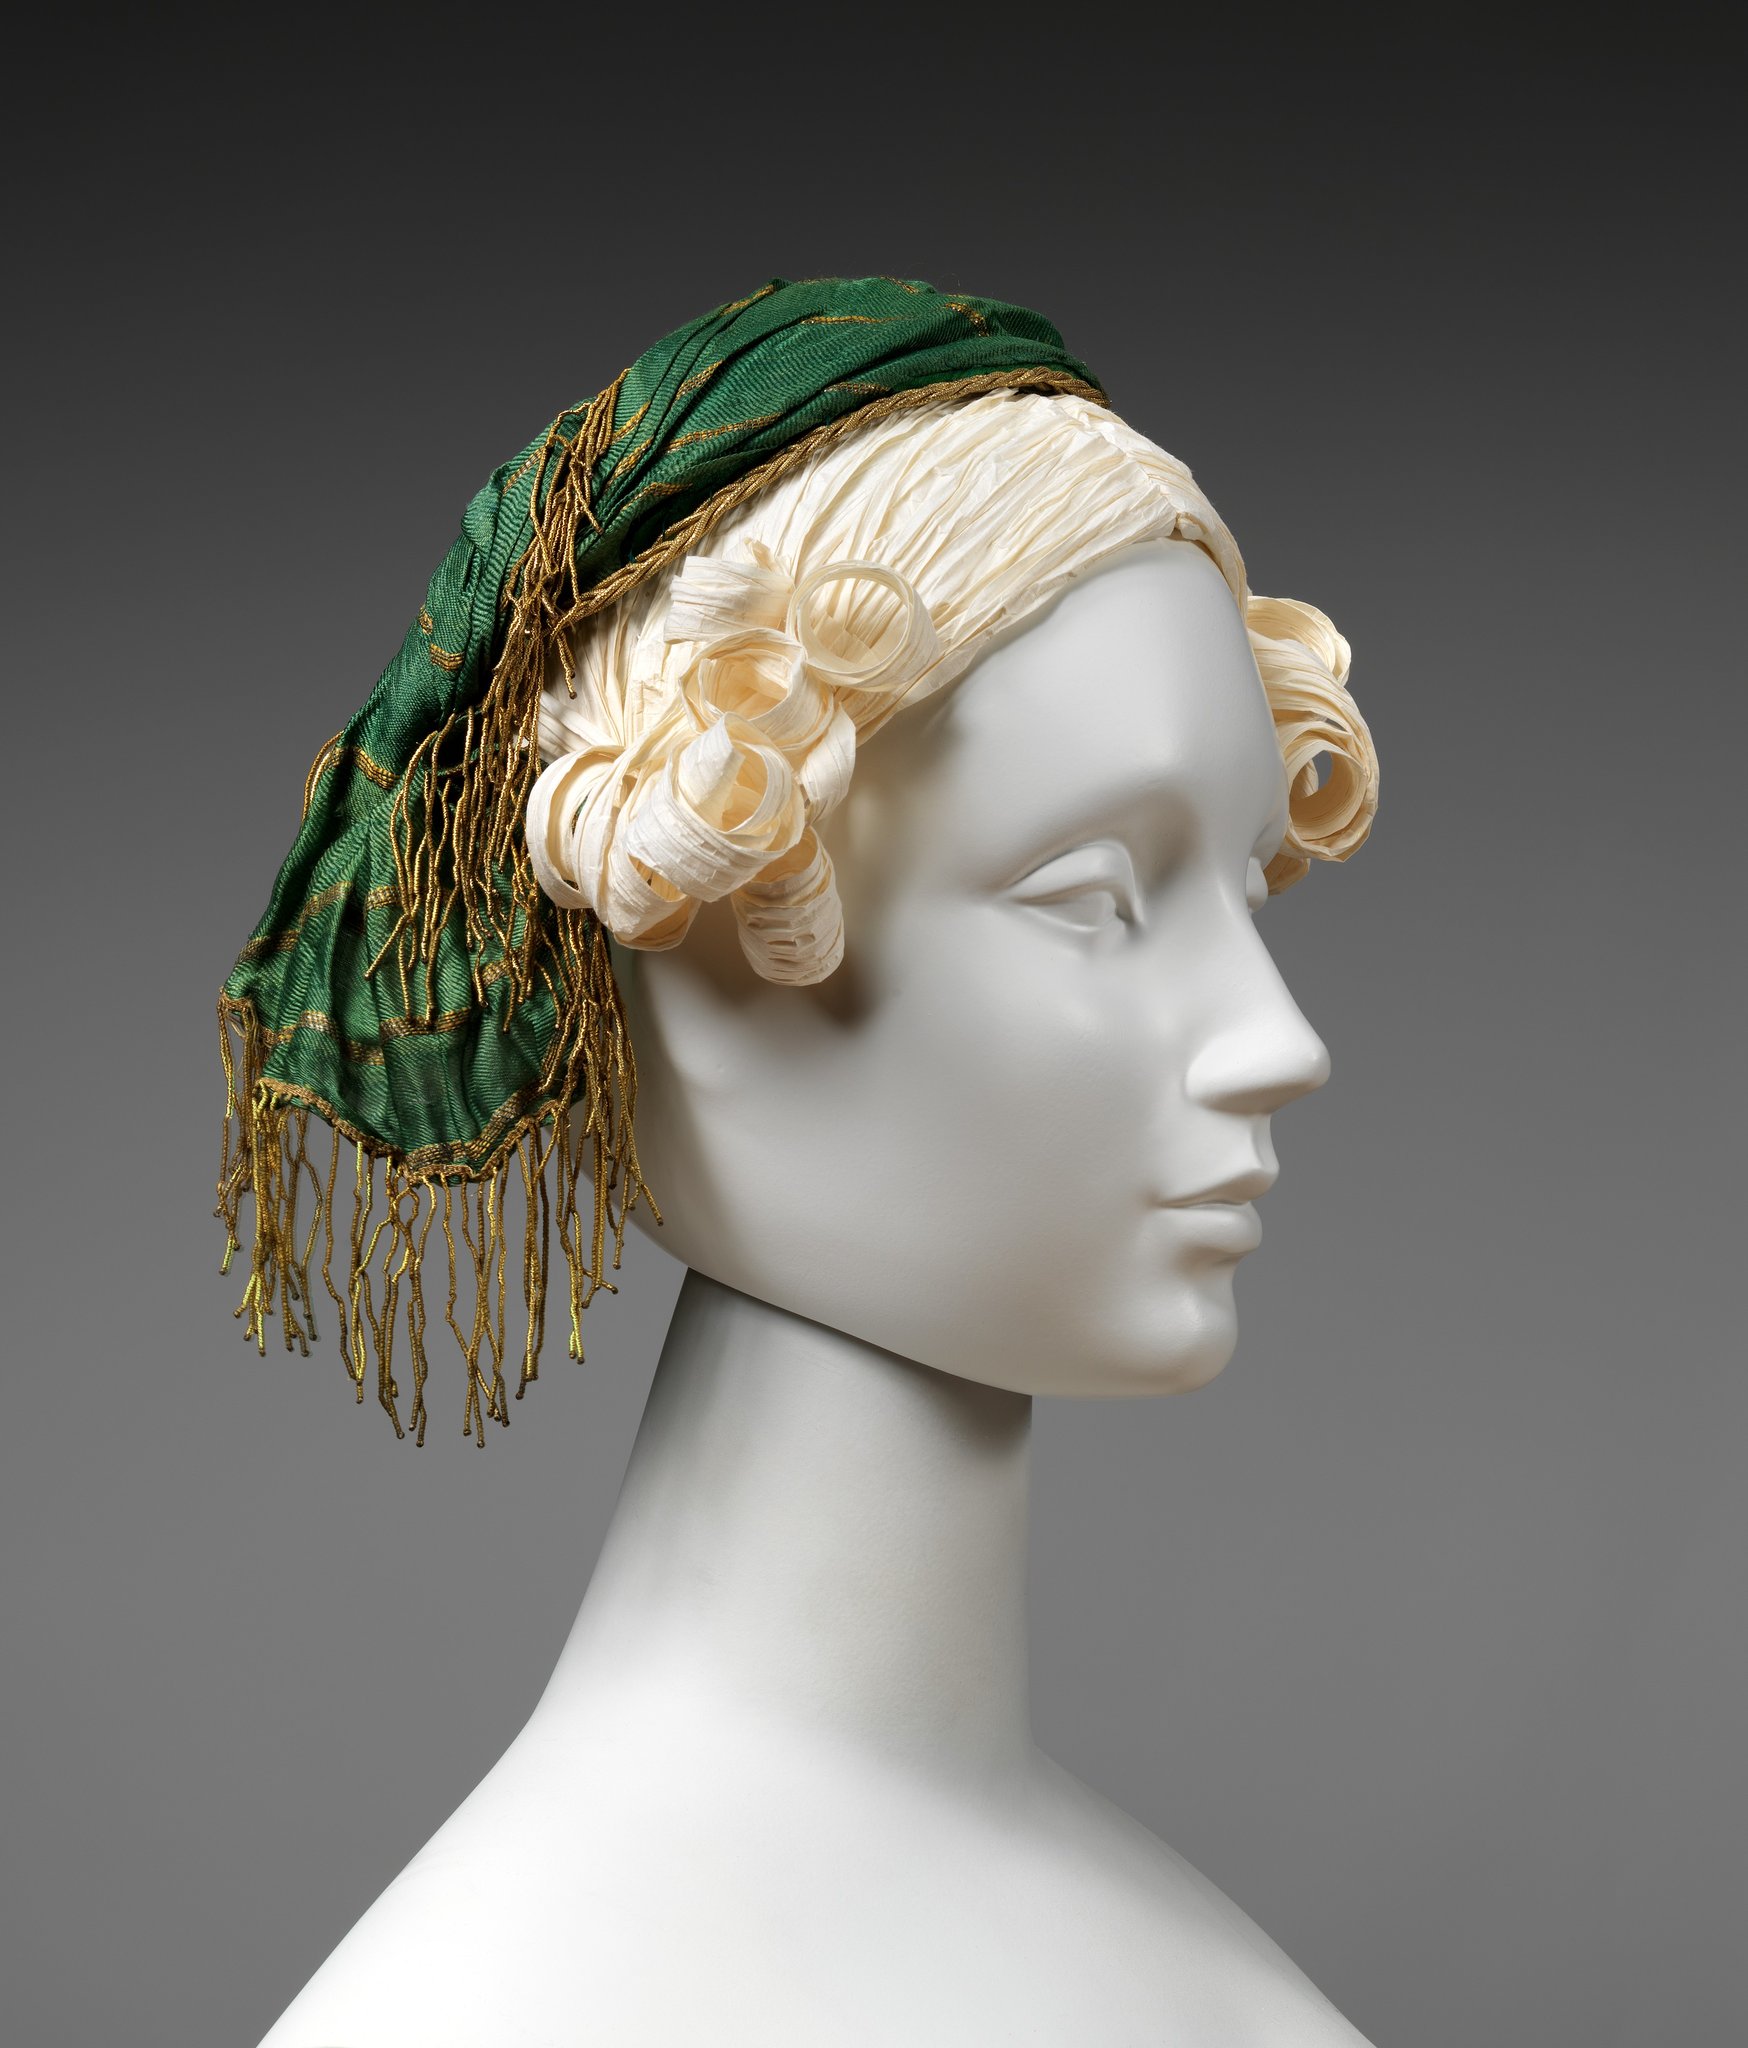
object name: headdress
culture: french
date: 1800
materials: metal, silk